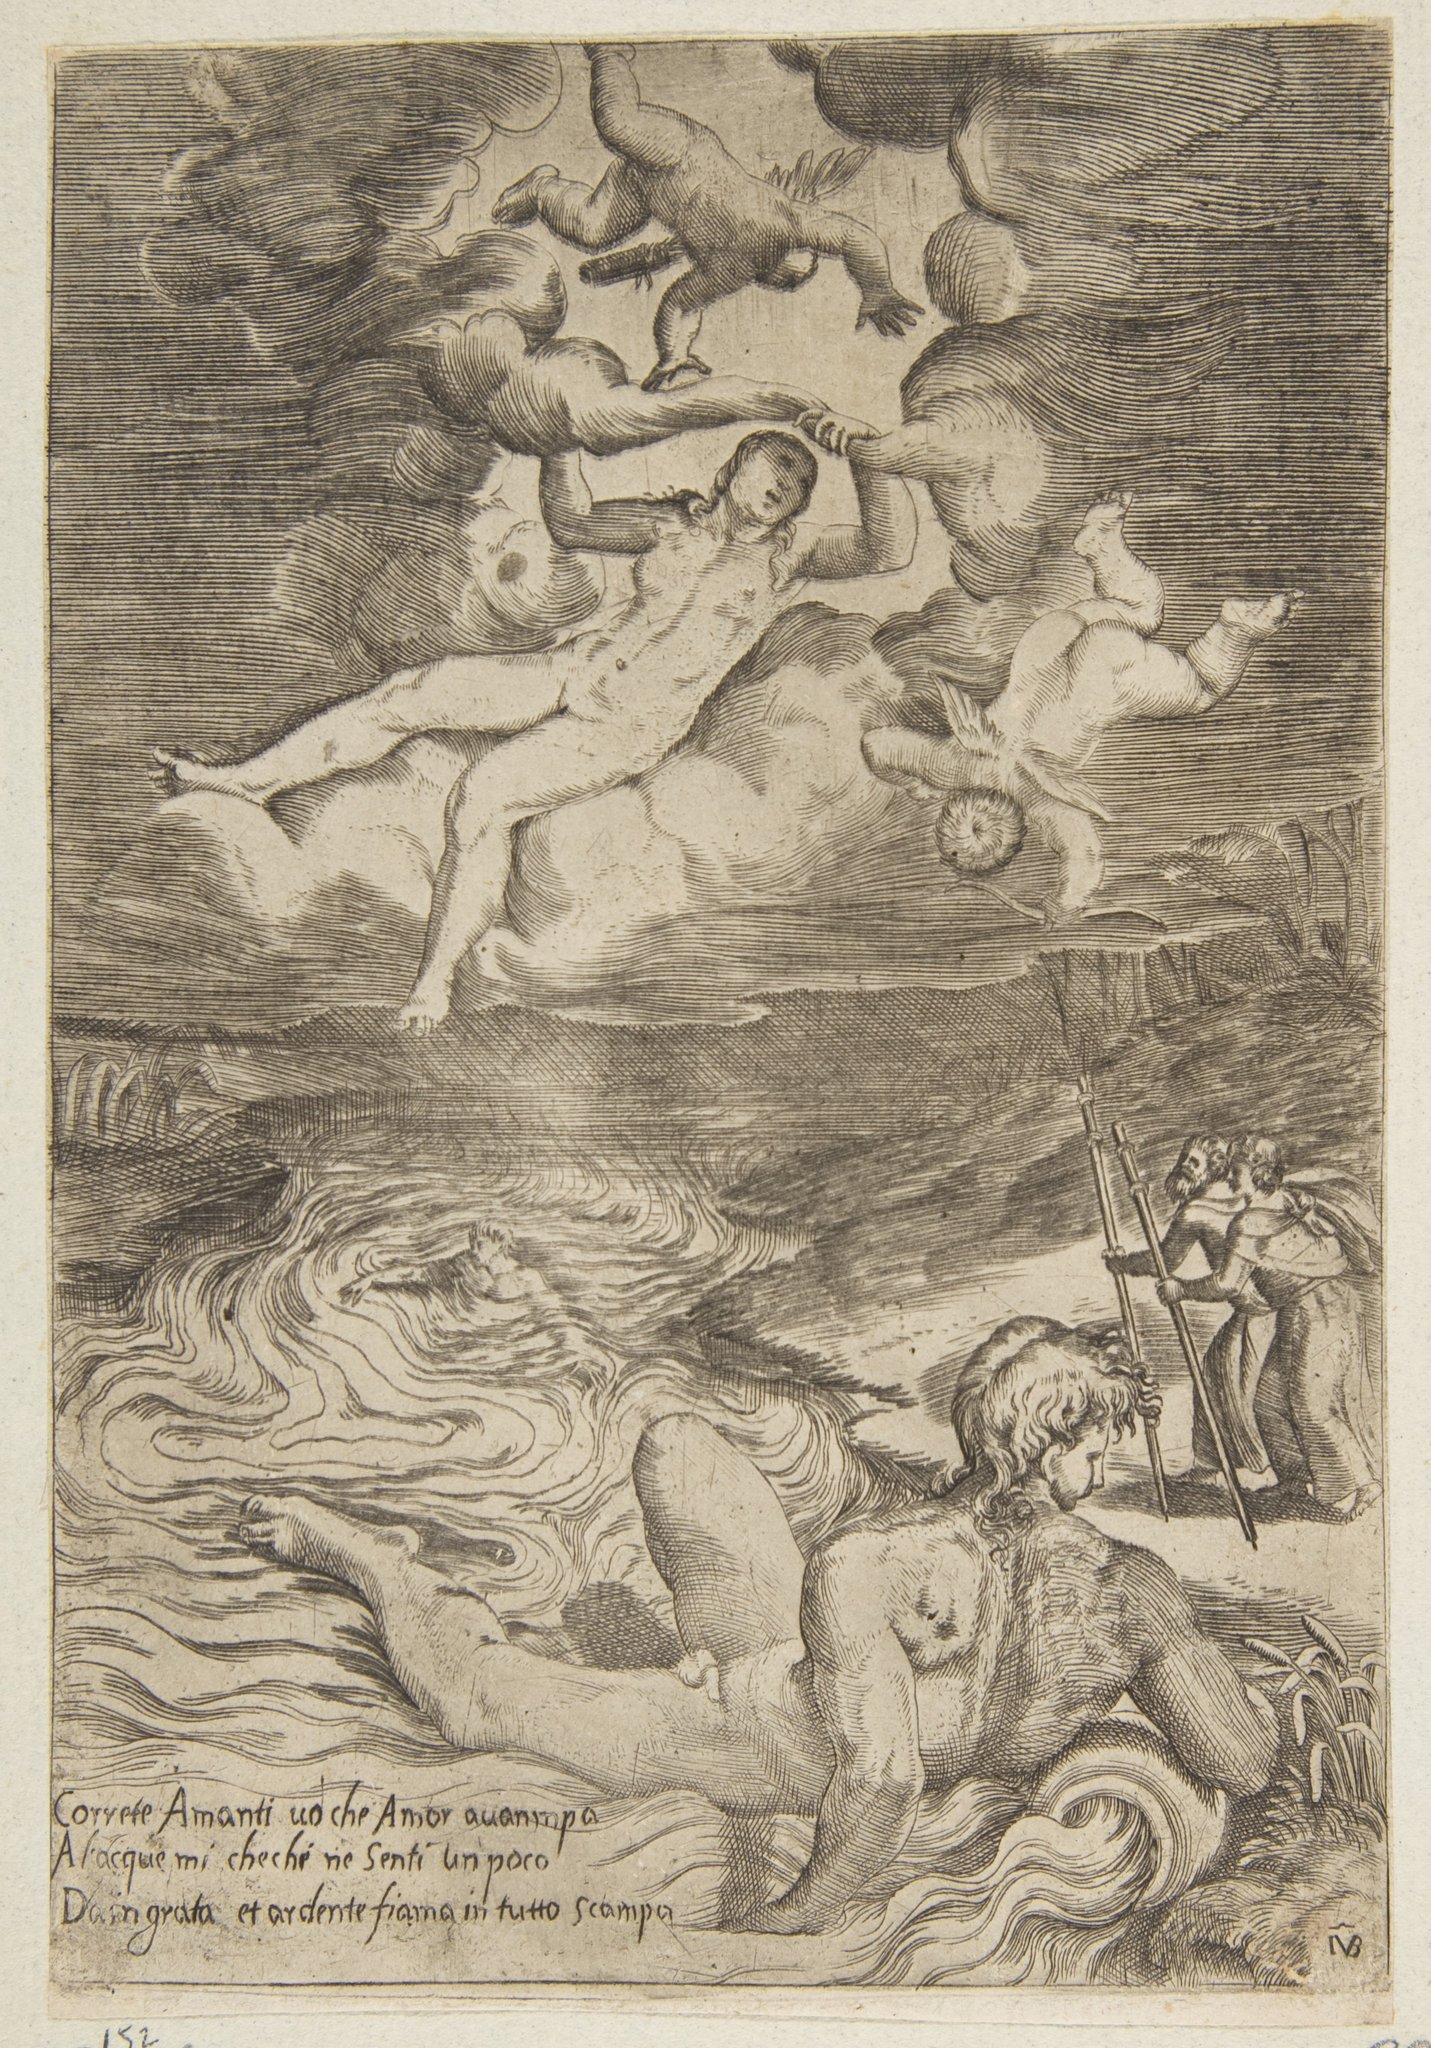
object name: print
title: Venus tumbling with putti in the clouds, from "The Loves of the Gods"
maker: giulio bonasone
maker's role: artist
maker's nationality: italian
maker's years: 1510-1576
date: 1531-1576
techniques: engraving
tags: putti,venus